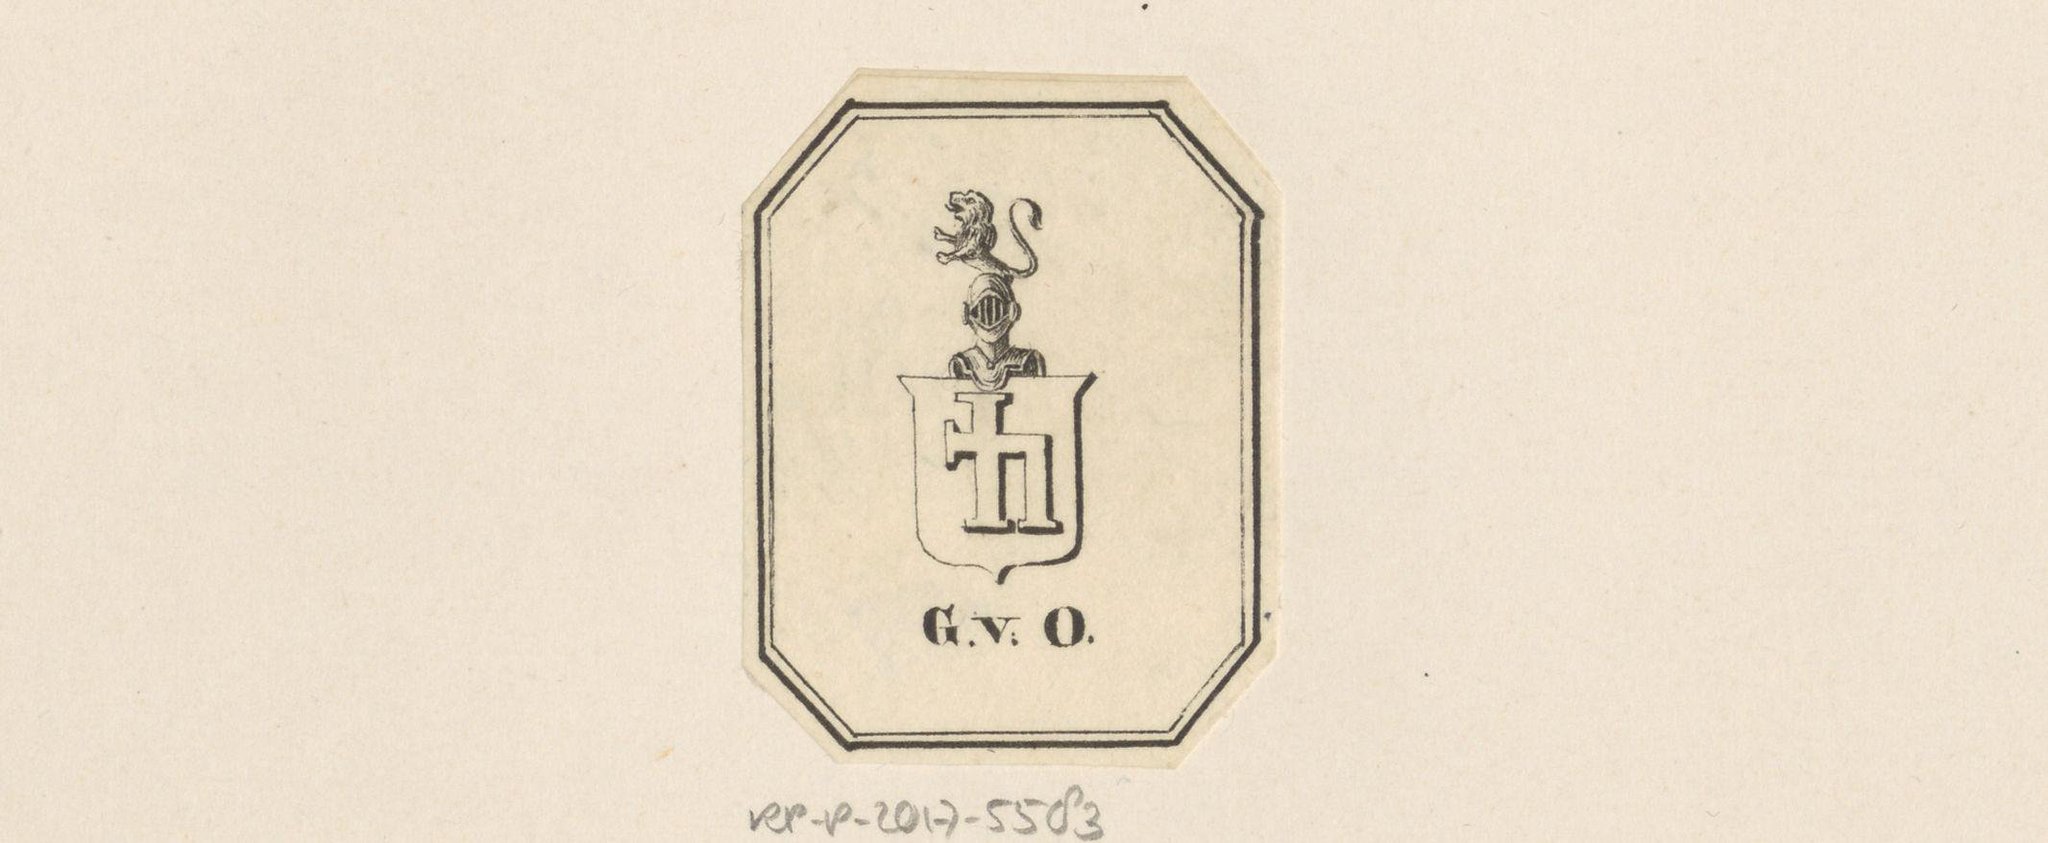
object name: bookplate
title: Ex libris van G.v.O.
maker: Anonymous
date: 1850-1924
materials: paper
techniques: etching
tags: armorial bearing, heraldry